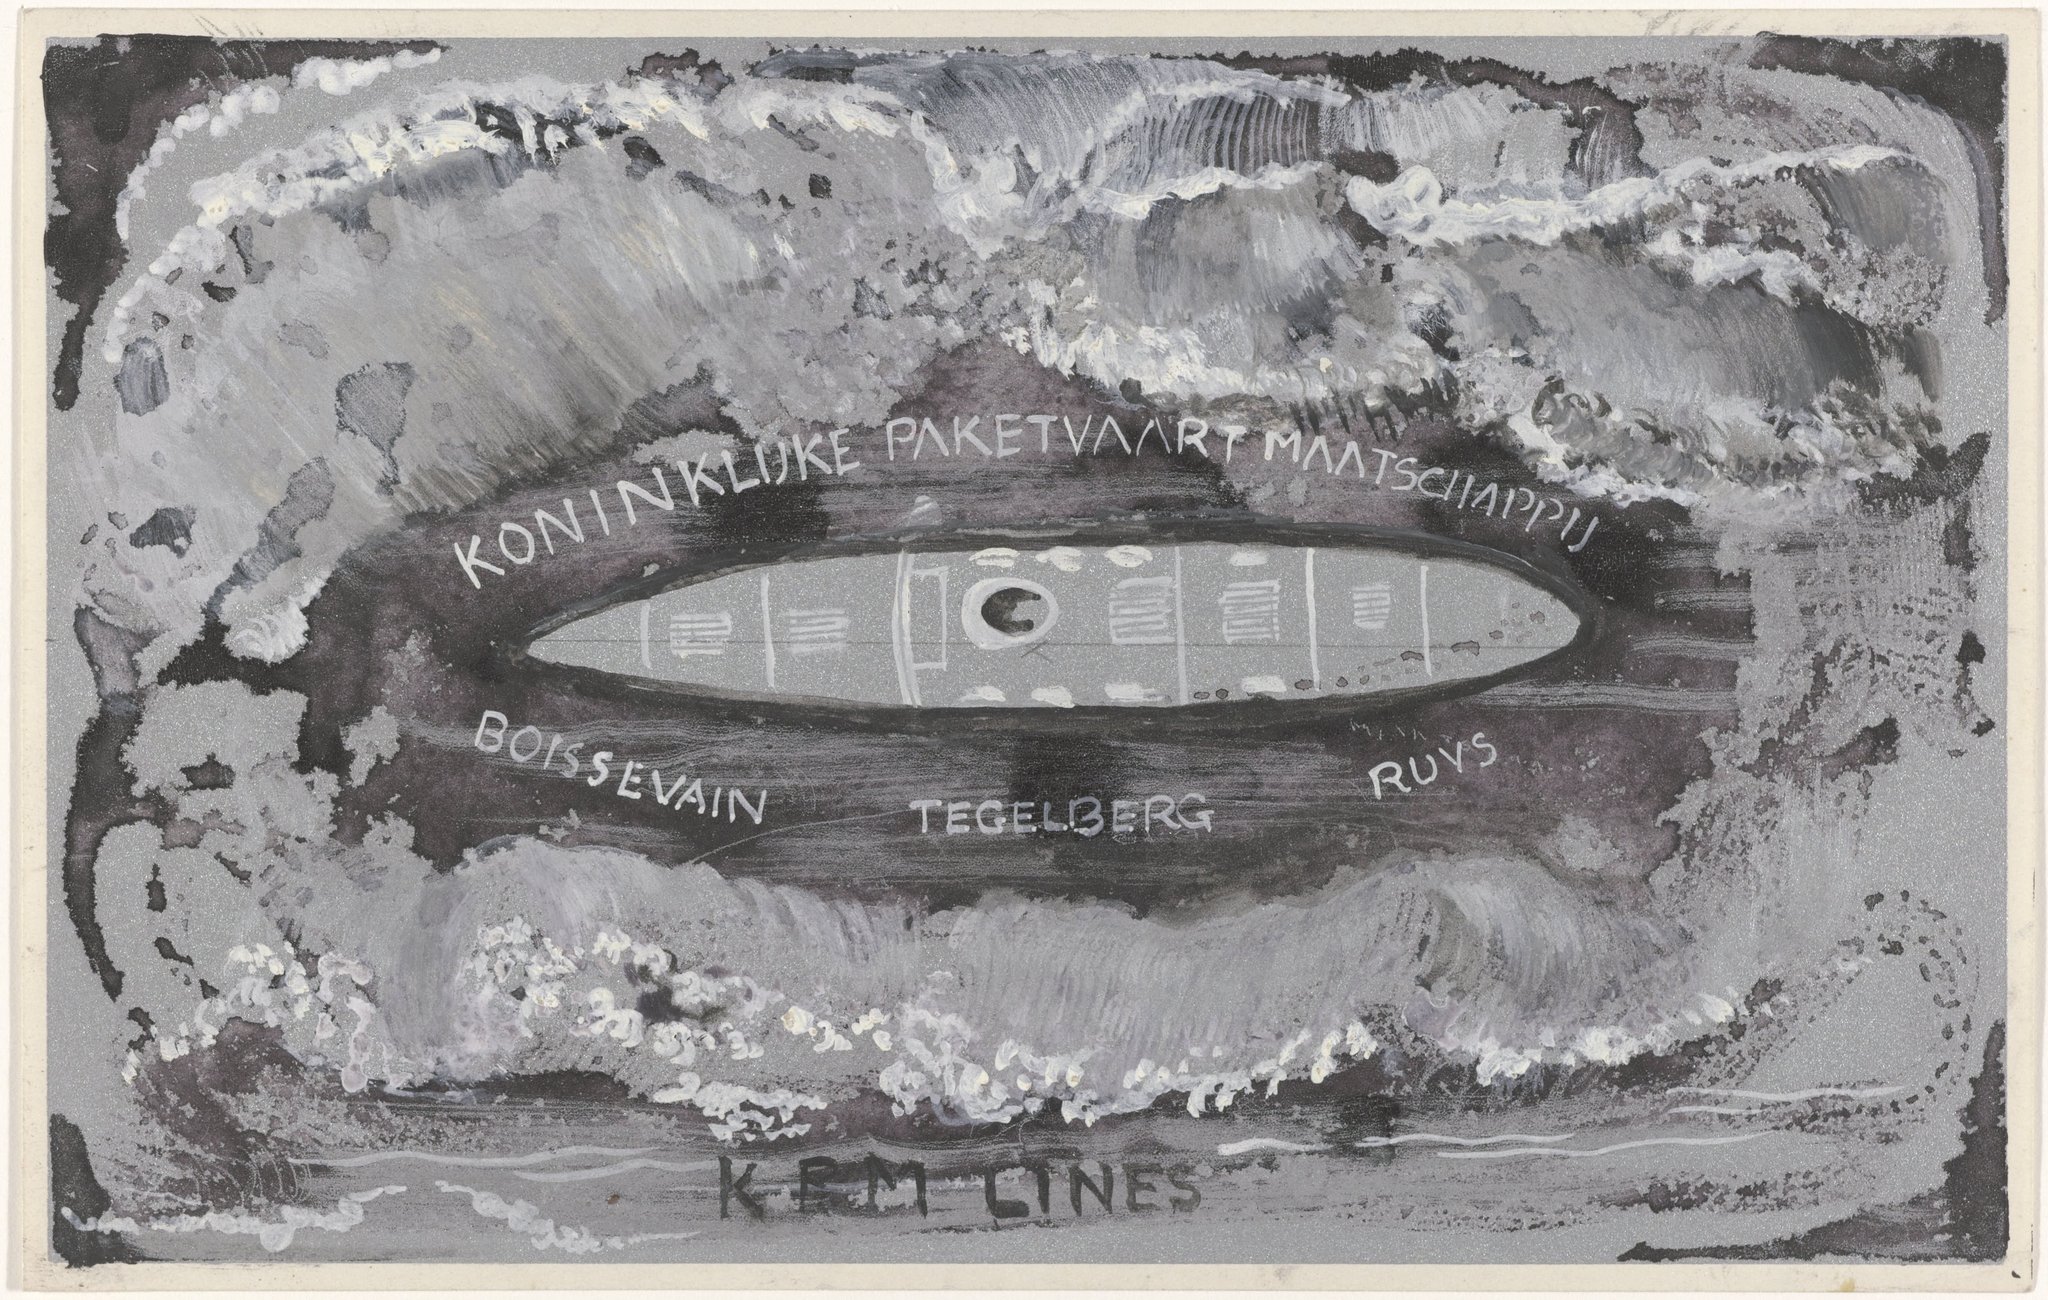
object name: drawing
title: Ontwerp voor vignet van de Koninklijke Paketvaart Maatschappij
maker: carel adolph lion cachet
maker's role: draughtsman, print maker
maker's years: 1864-1945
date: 1874-1945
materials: pencil, paper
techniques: brush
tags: frontispiece, names of organizations, companies, trade unions, etc., steamship, motorship